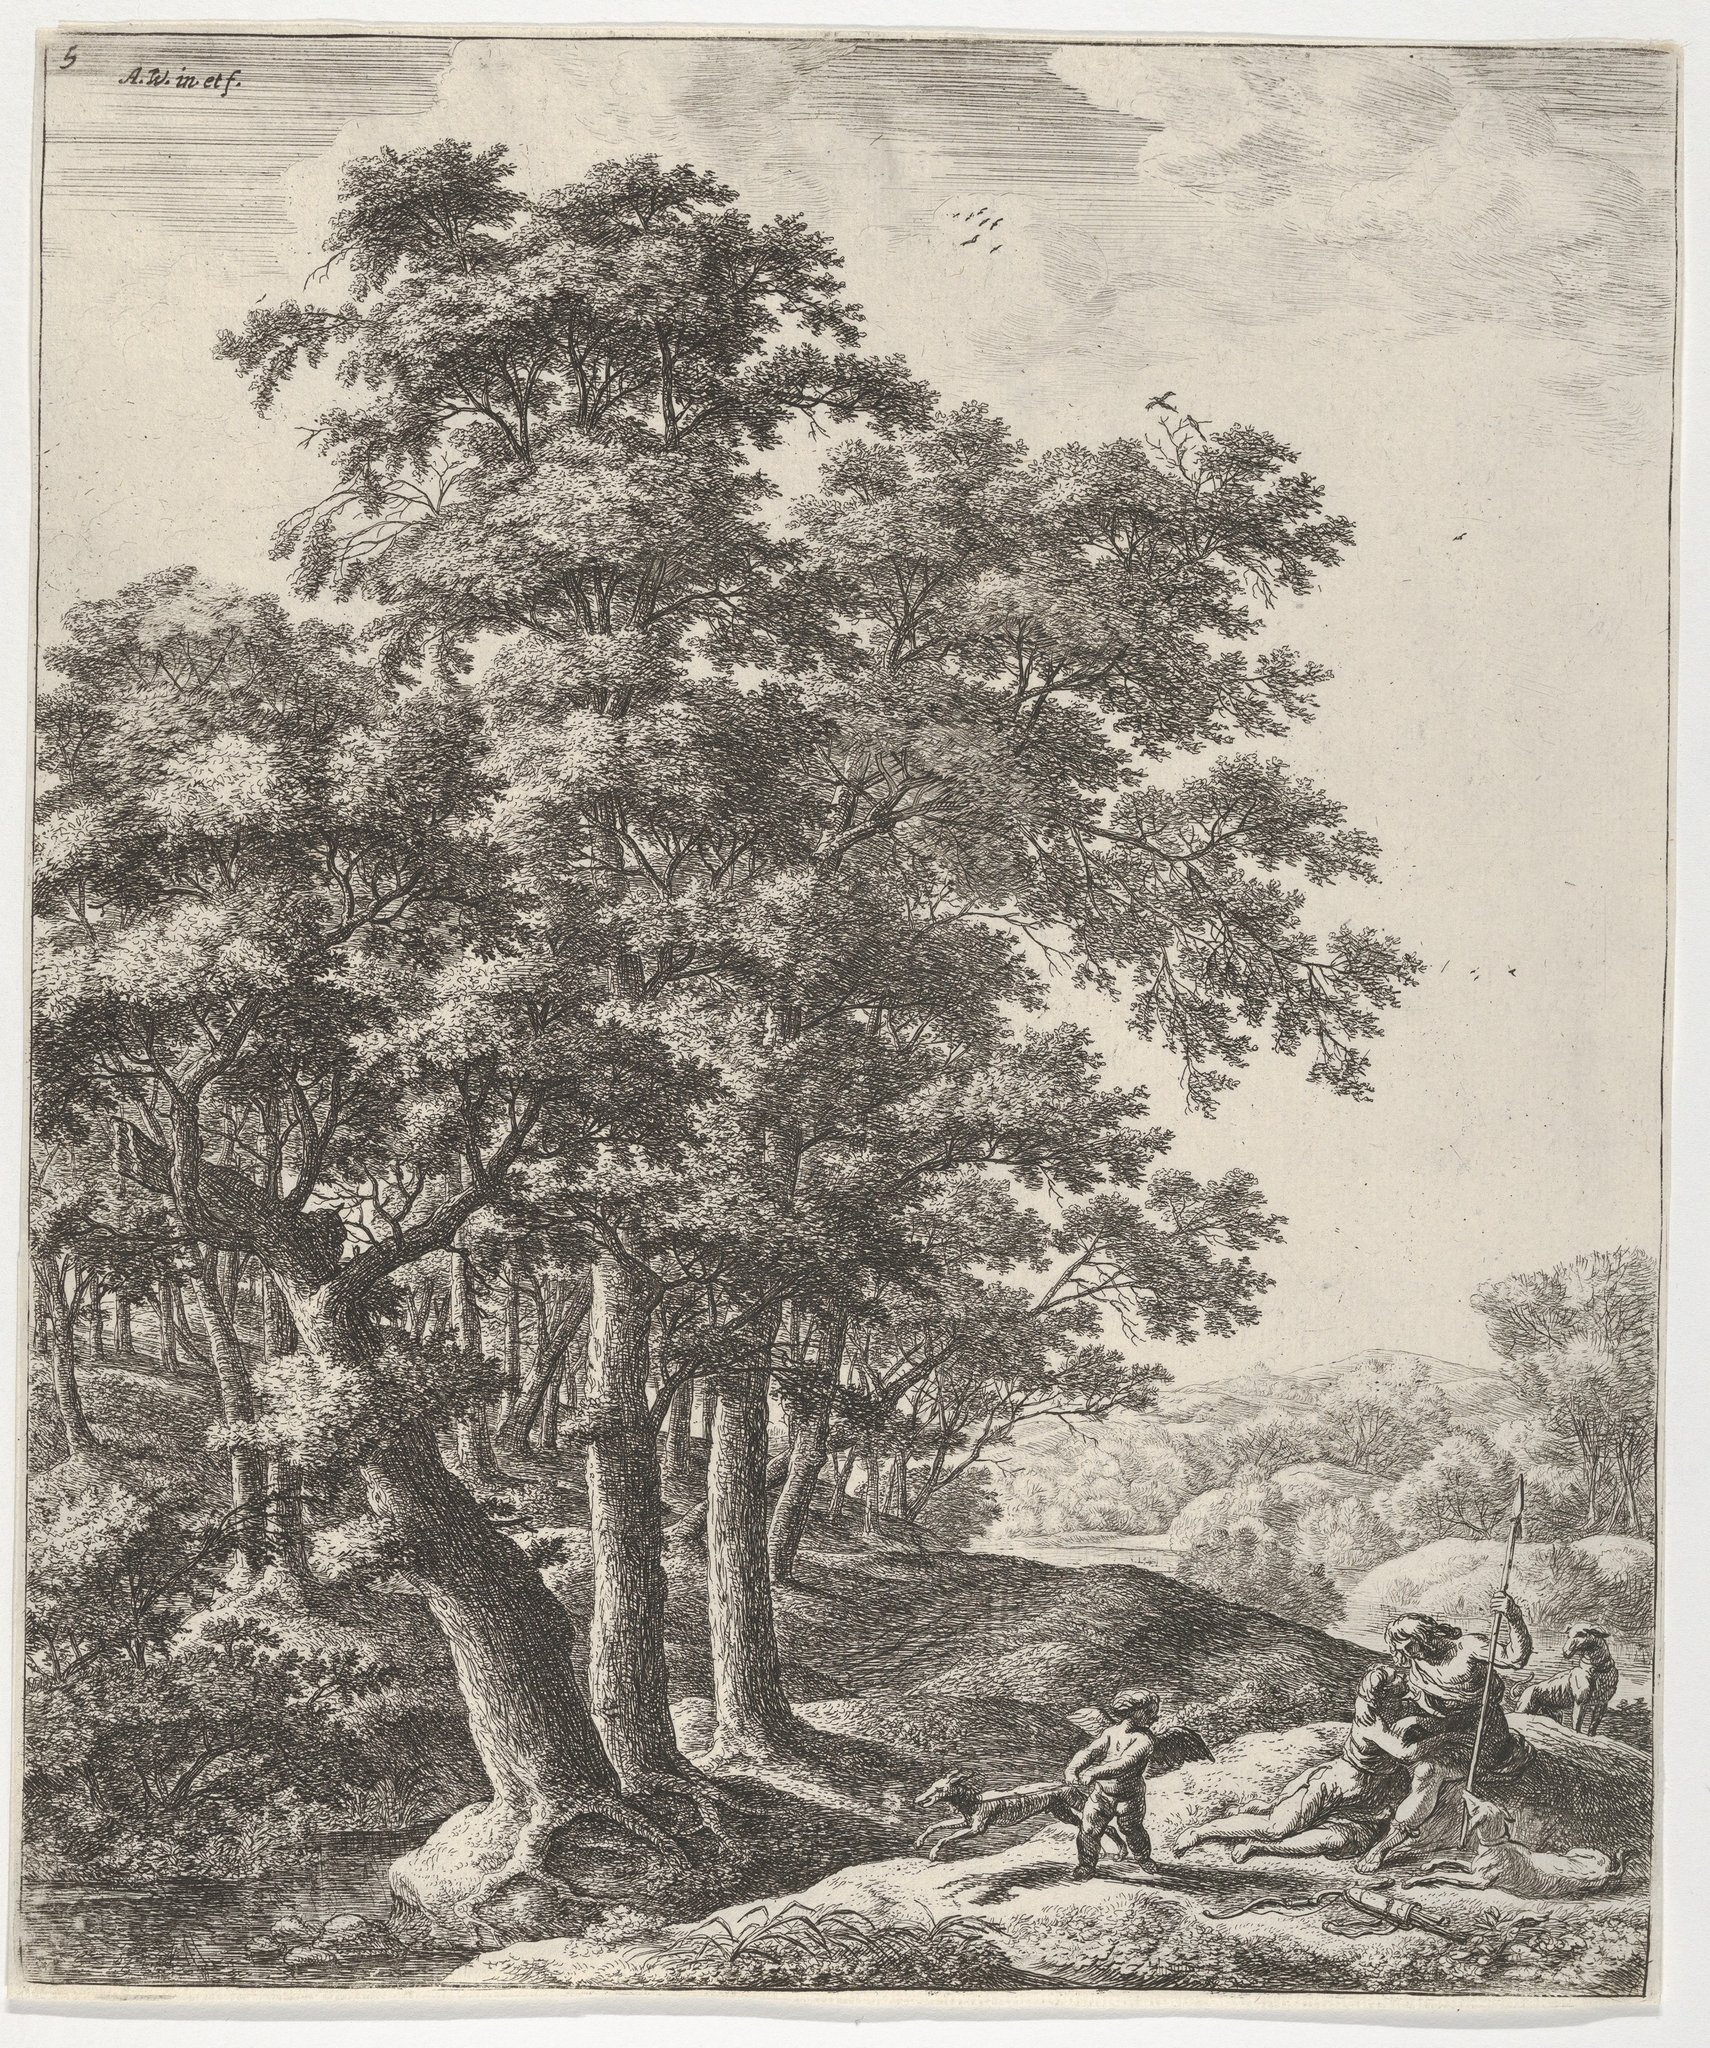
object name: print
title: Landscape with Venus and Adonis, from the Series of Six Mythological Scenes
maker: anthonie waterloo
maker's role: artist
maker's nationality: dutch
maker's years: 1609-1690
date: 1601-1700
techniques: etching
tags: adonis,venus,dogs,landscapes,trees